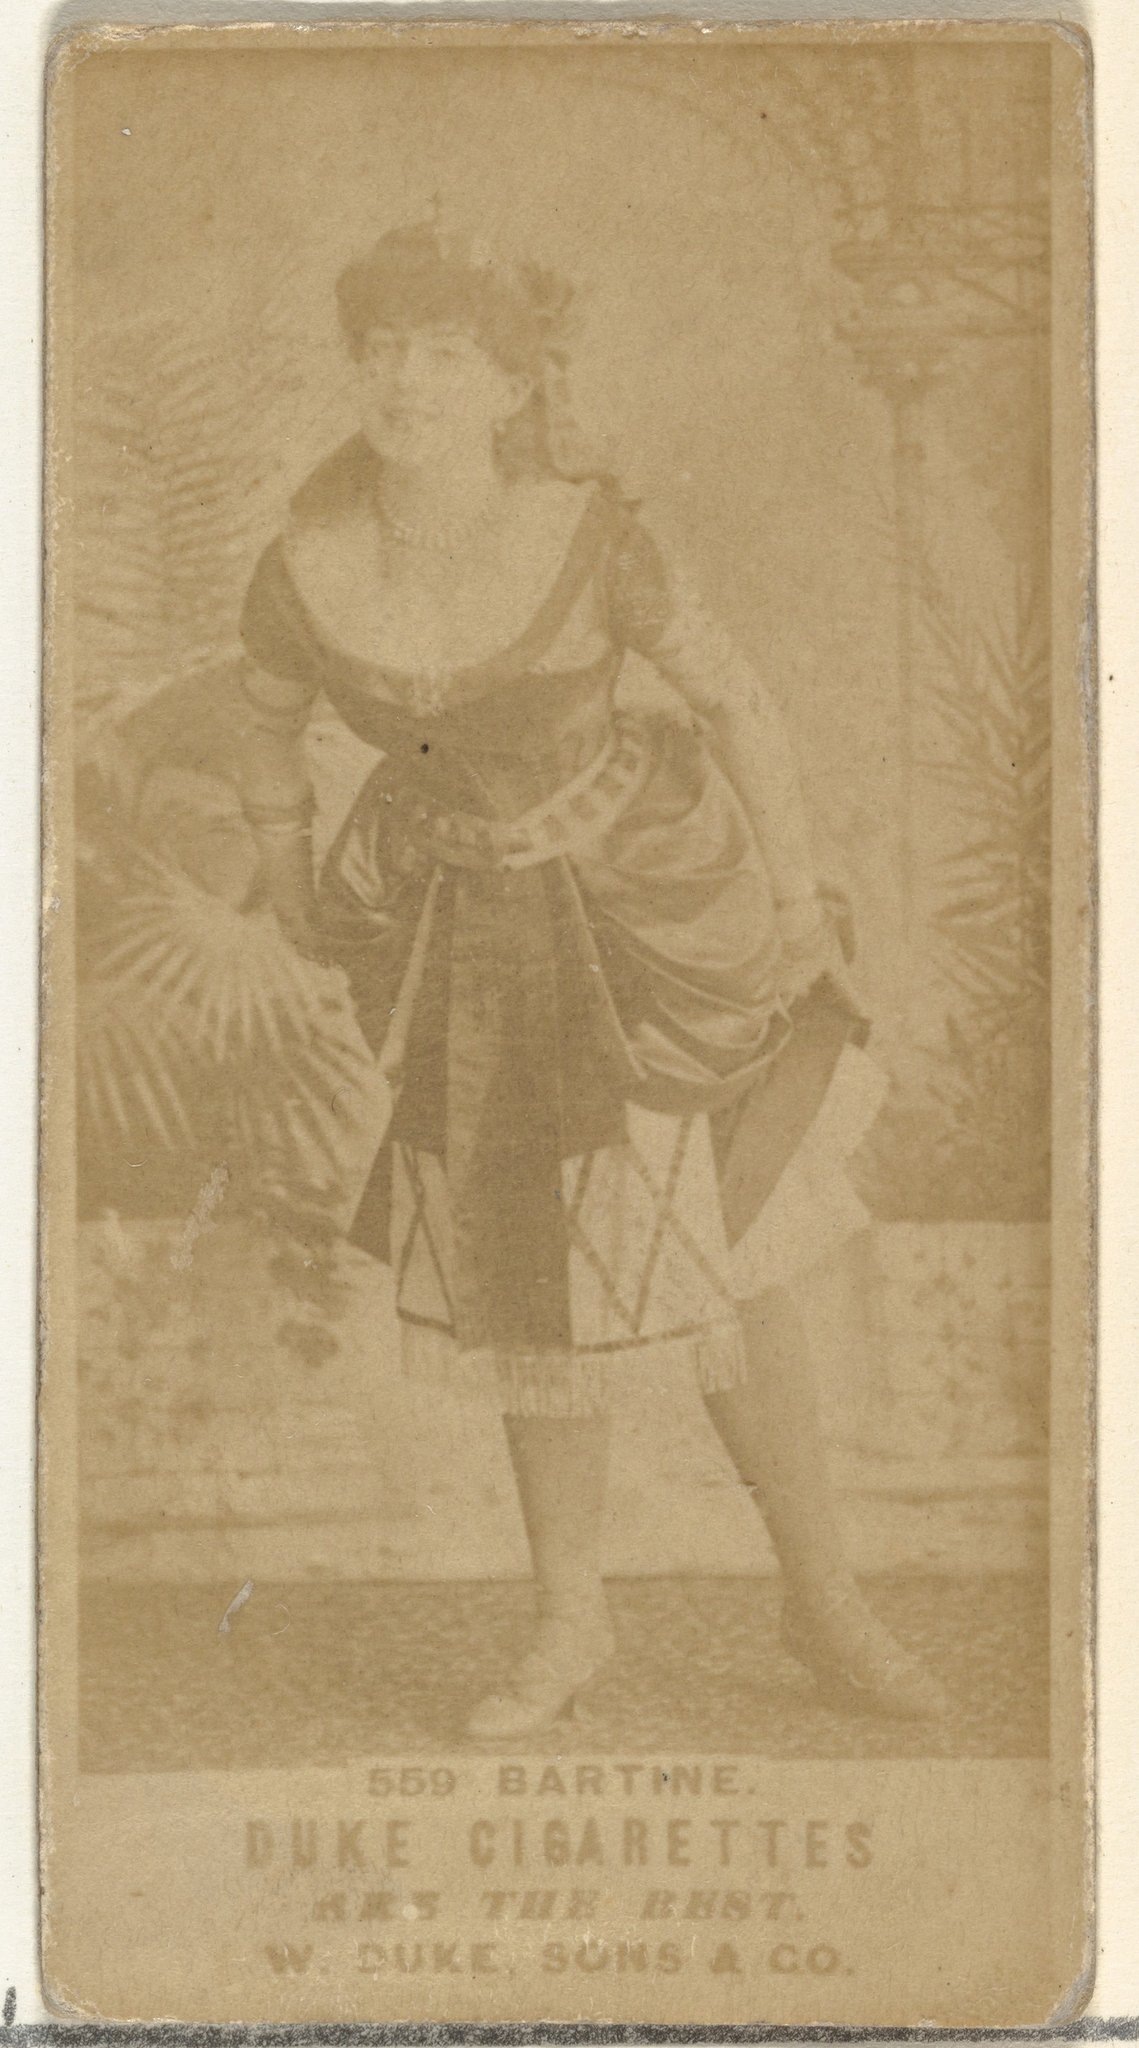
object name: photograph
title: Card Number 559, Miss Bartine, from the Actors and Actresses series (N145-7) issued by Duke Sons & Co. to promote Duke Cigarettes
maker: w. duke, sons & co.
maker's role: publisher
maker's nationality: american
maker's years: 1870-1920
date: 1880-1889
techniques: albumen silver print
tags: portraits,women,actresses